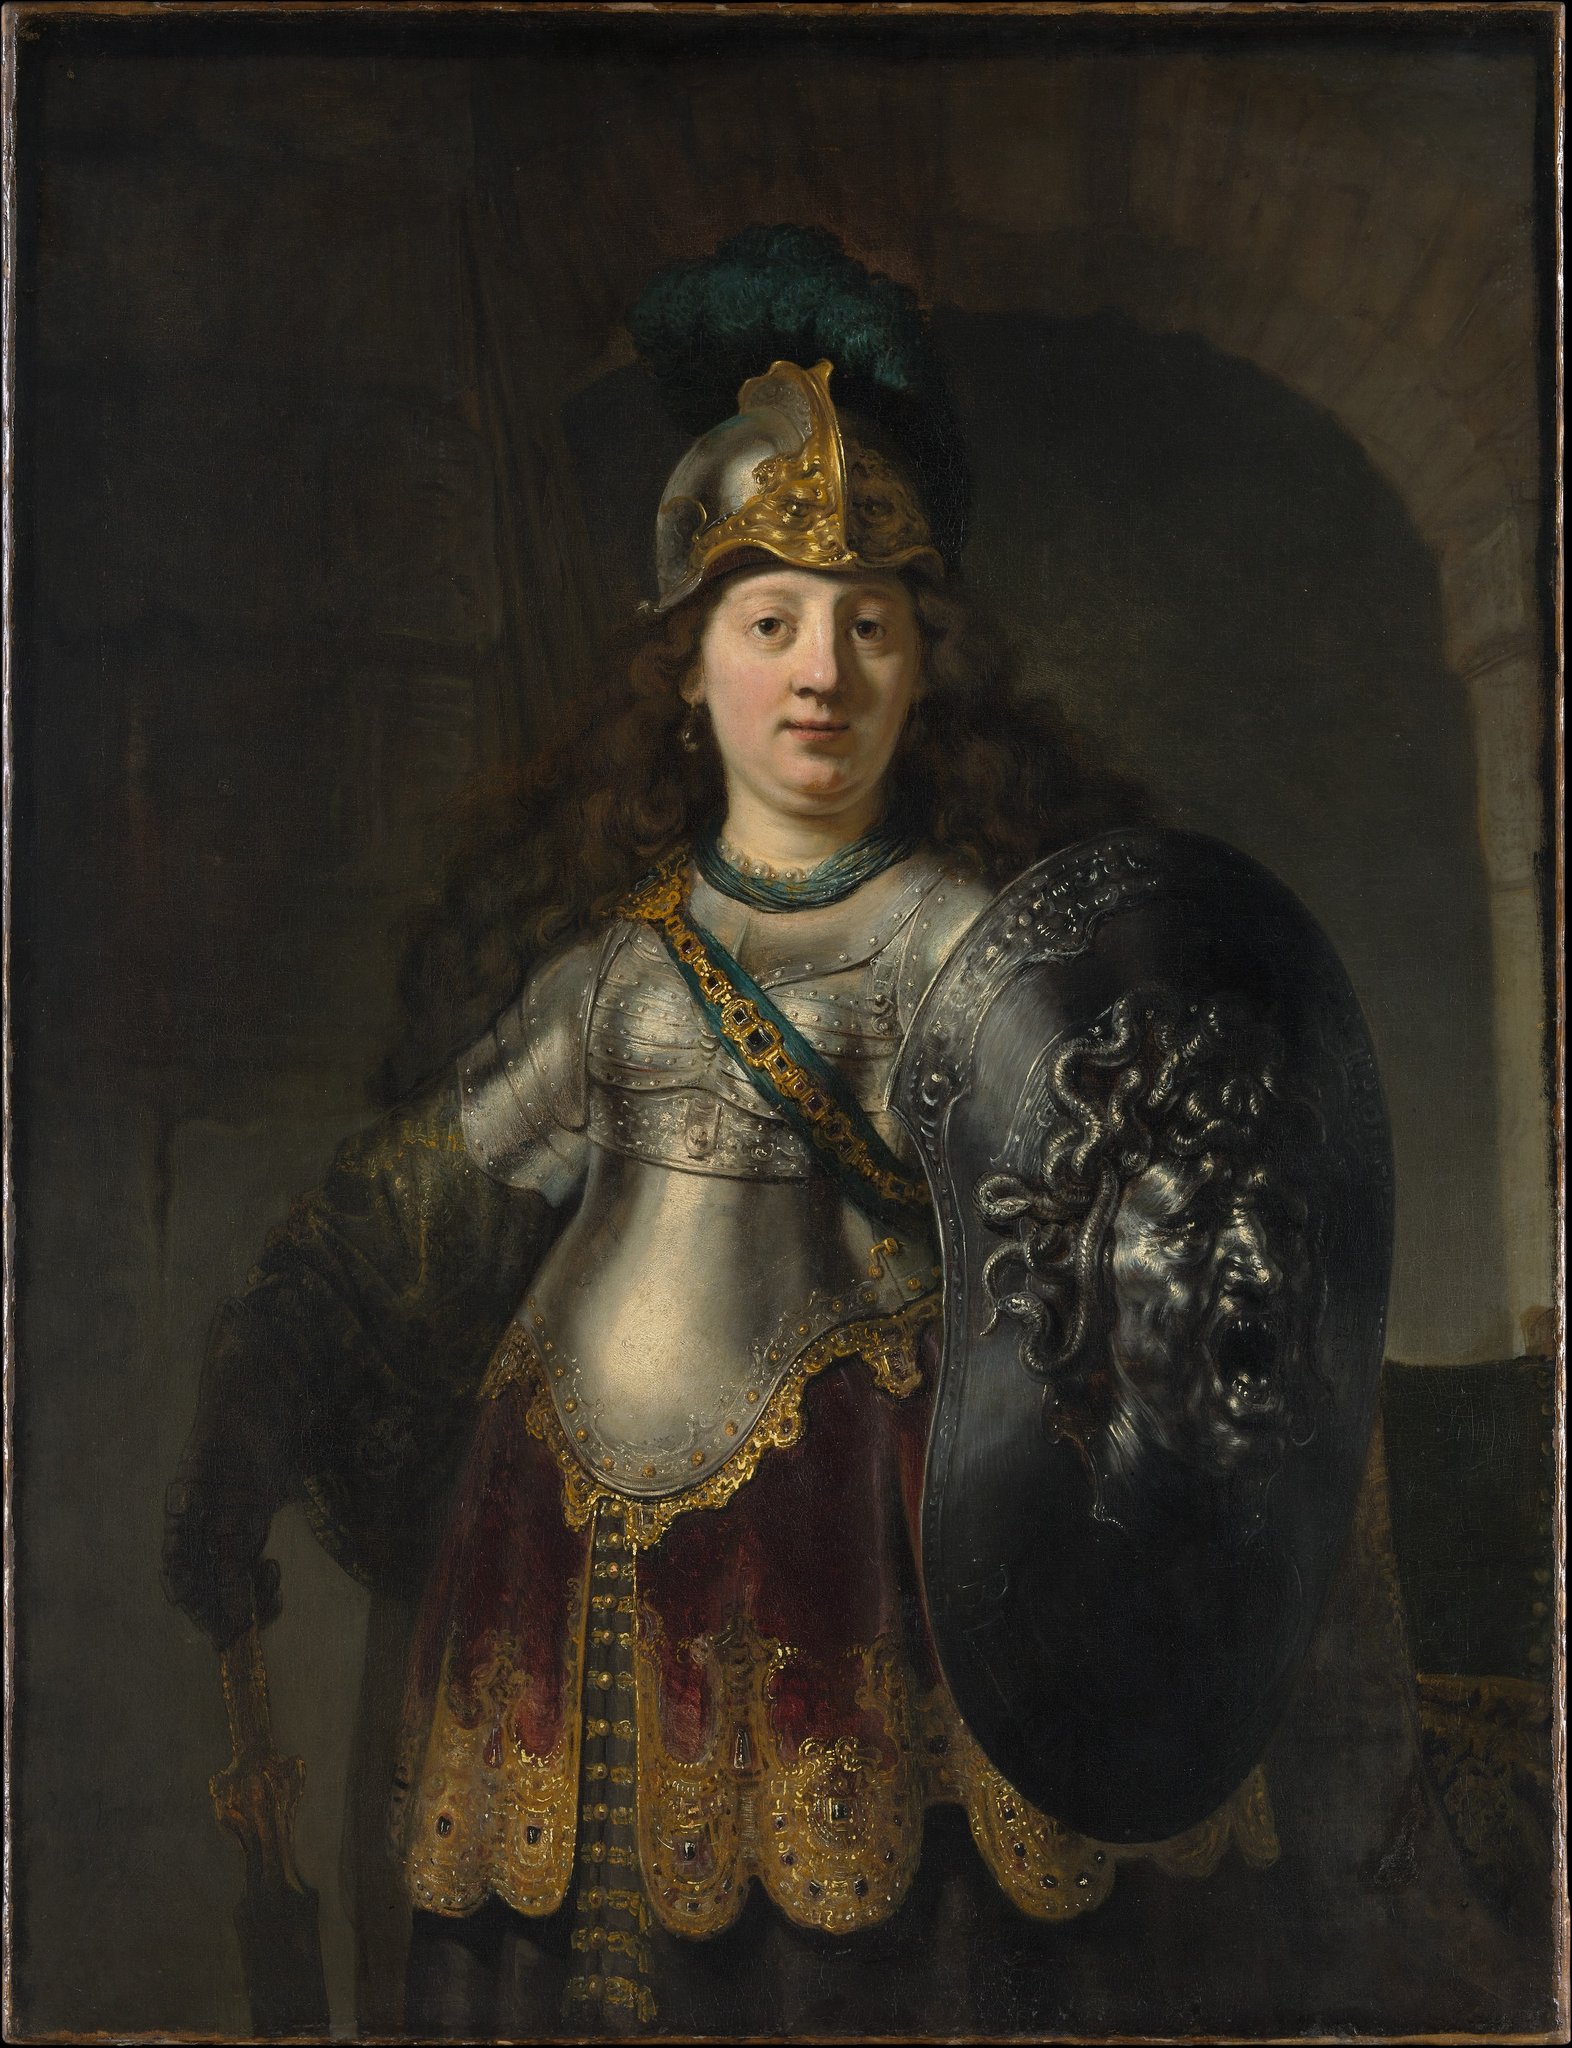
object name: painting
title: Bellona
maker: rembrandt van rijn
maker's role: artist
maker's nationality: dutch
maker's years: 1606-1669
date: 1633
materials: canvas, oil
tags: armor,women,goddess